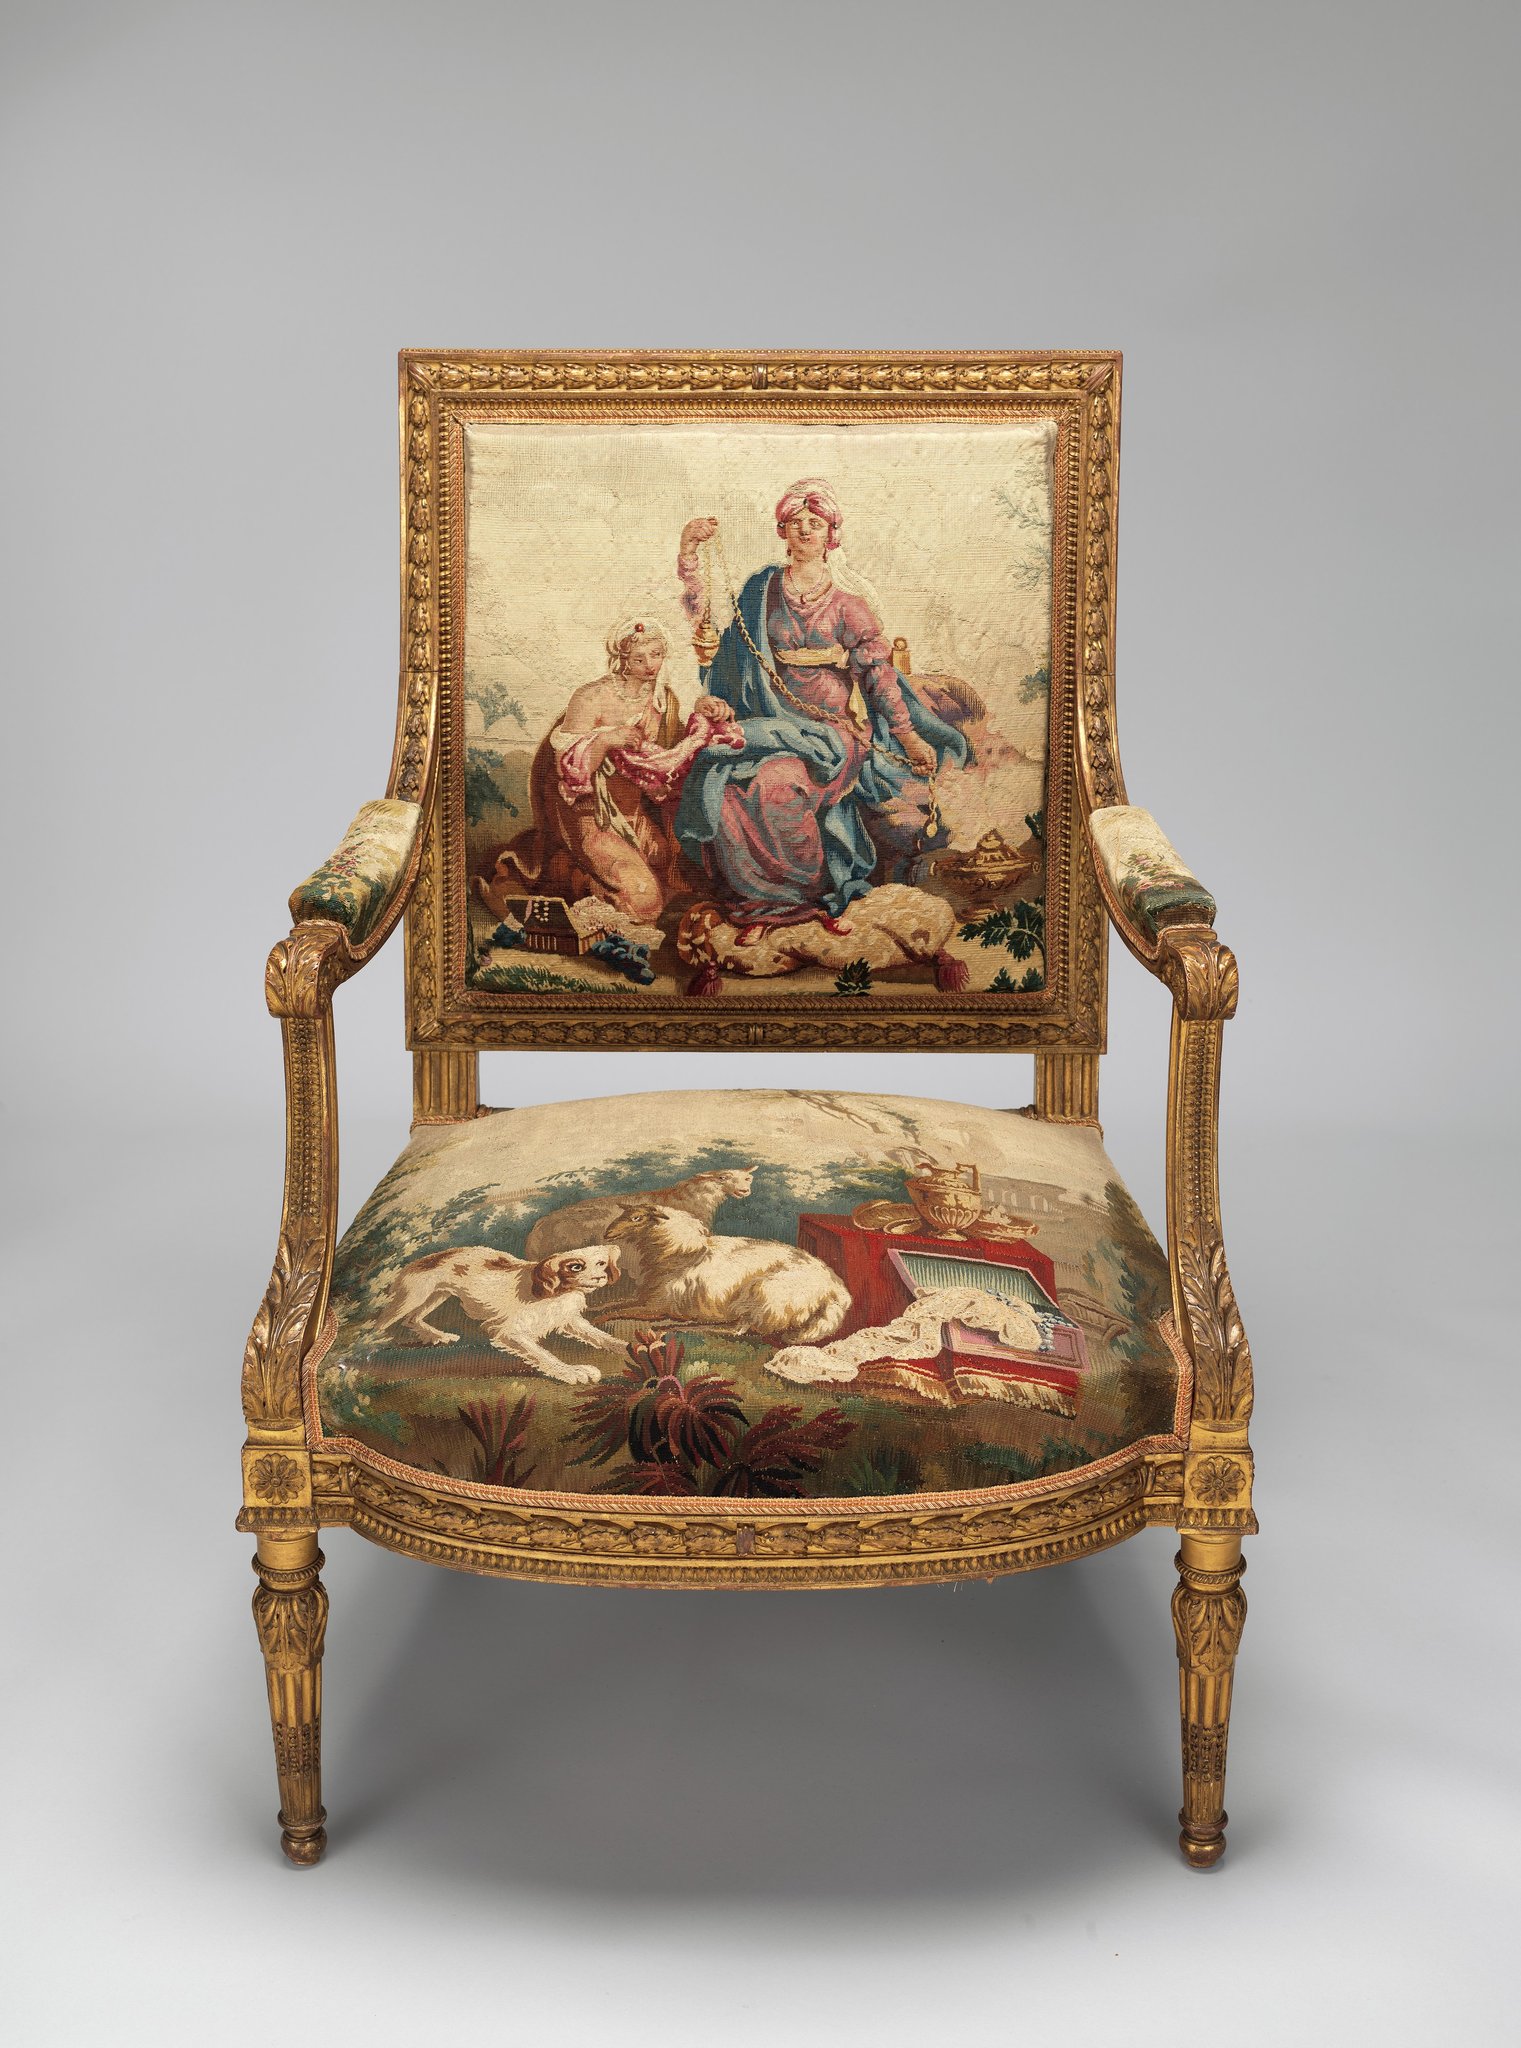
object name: armchair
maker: beauvais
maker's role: manufactory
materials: silk, wood, wool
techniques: carving, gilding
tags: women,dogs,sheep